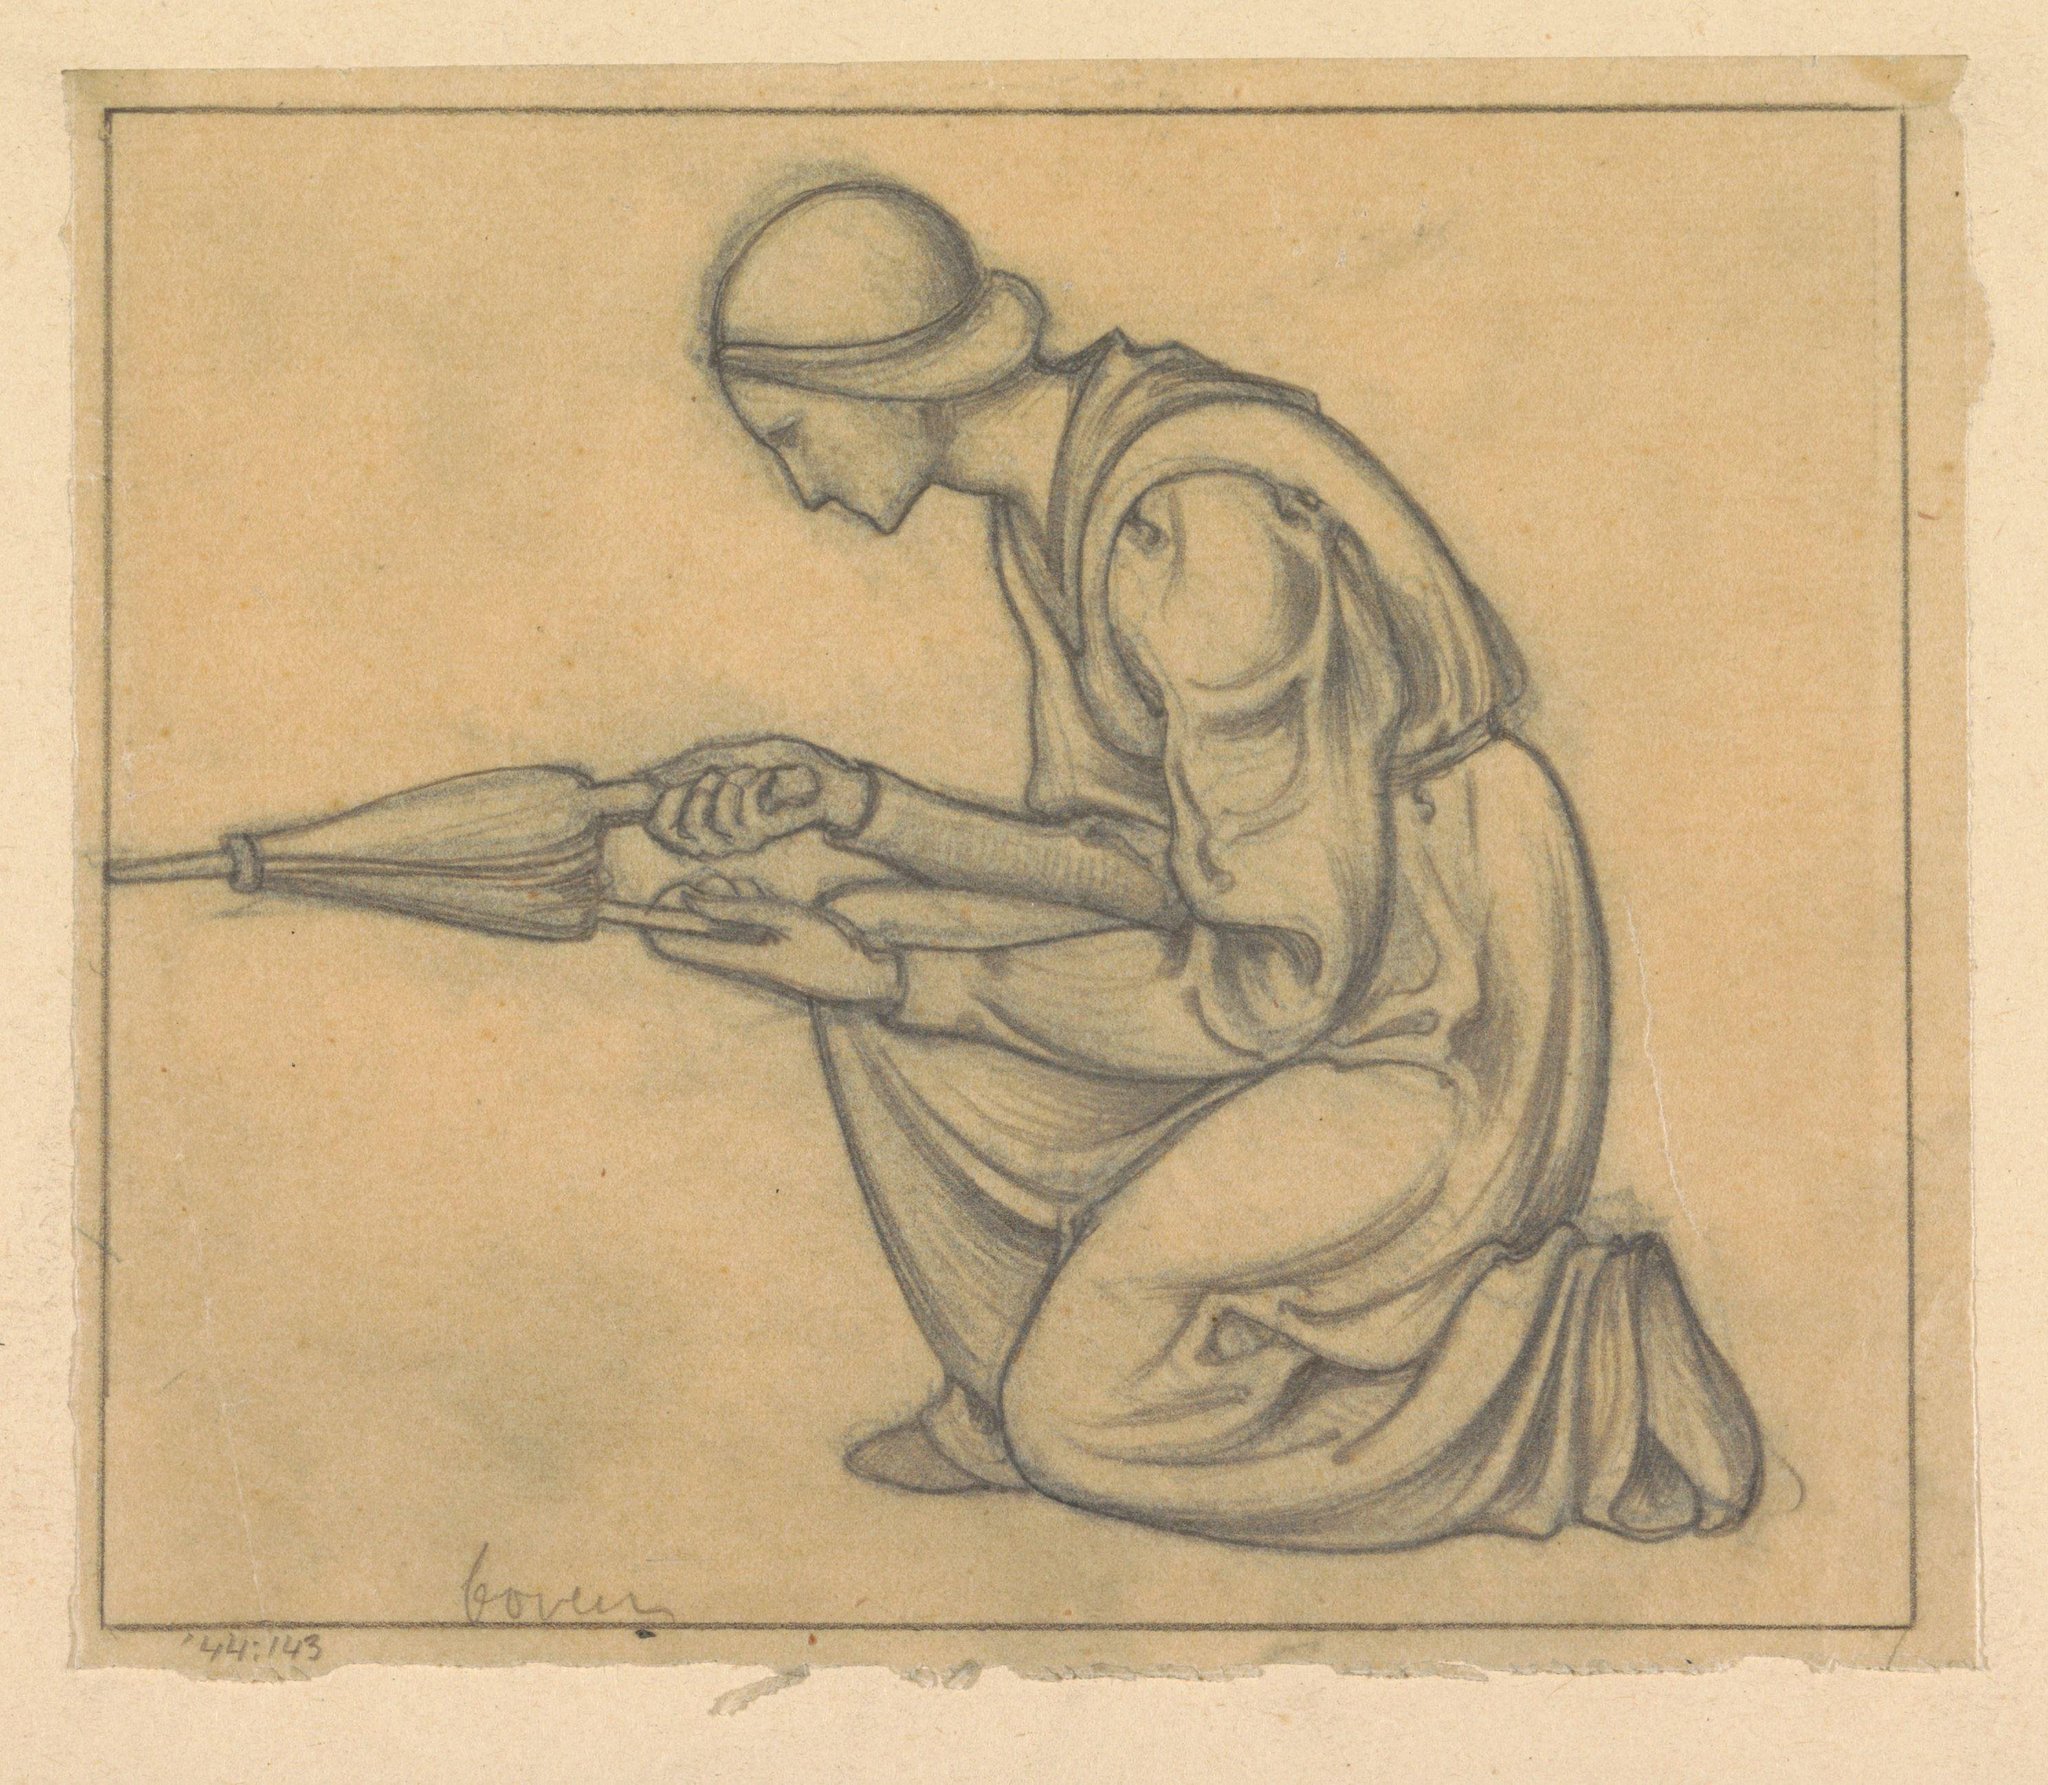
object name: drawing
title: Ontwerp voor wandschildering in de Beurs van Berlage: knielende vrouw met blaasbalg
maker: antoon derkinderen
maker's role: draughtsman, painter, print maker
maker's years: 1859-1925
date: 1869-1925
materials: pencil, paper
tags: bellows